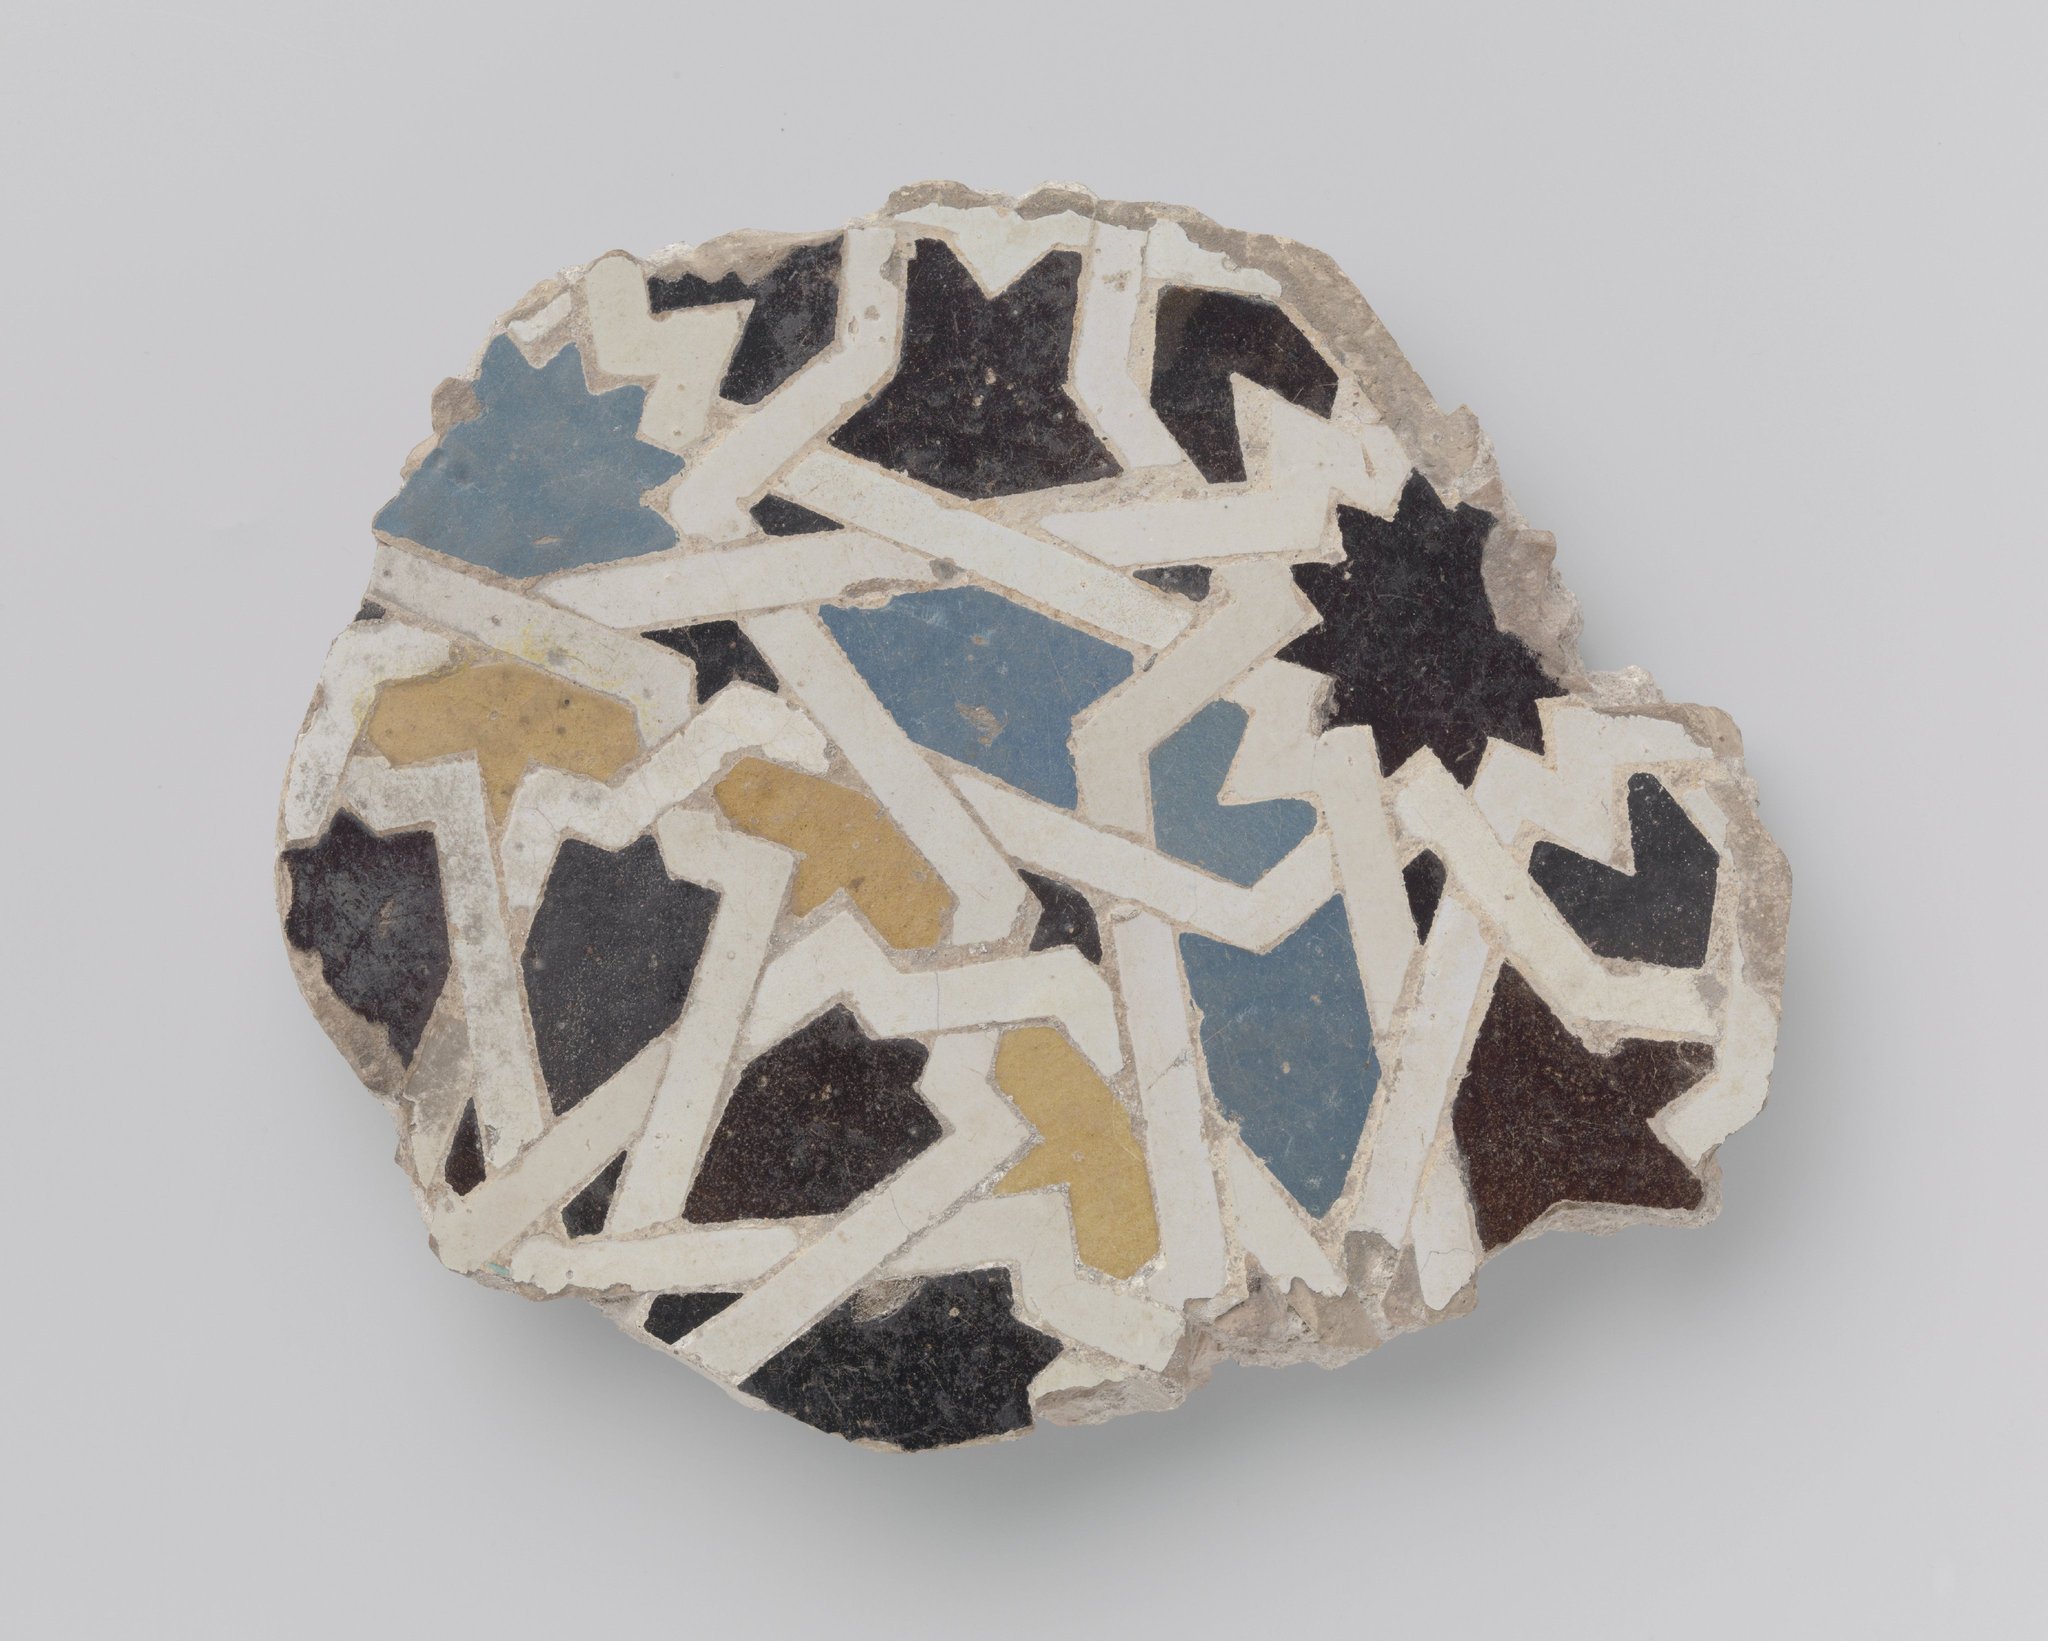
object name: tile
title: Tile Mosaic Fragment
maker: Anonymous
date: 1300-1400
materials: earthenware, glaze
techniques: wood inlay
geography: andalusia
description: The oldest wall decorations in Islamic Spain were mosaics made of variously shaped coloured tile pieces arranged in intricate geometric patterns. This was a time-consuming and therefore expensive technique. Only the very rich could afford such wall mosaics. The geometric pattern on this fragment is almost identical to a mosaic from the Alhambra in Granada. Perhaps it originally came from this palace, or was made in the same workshop.